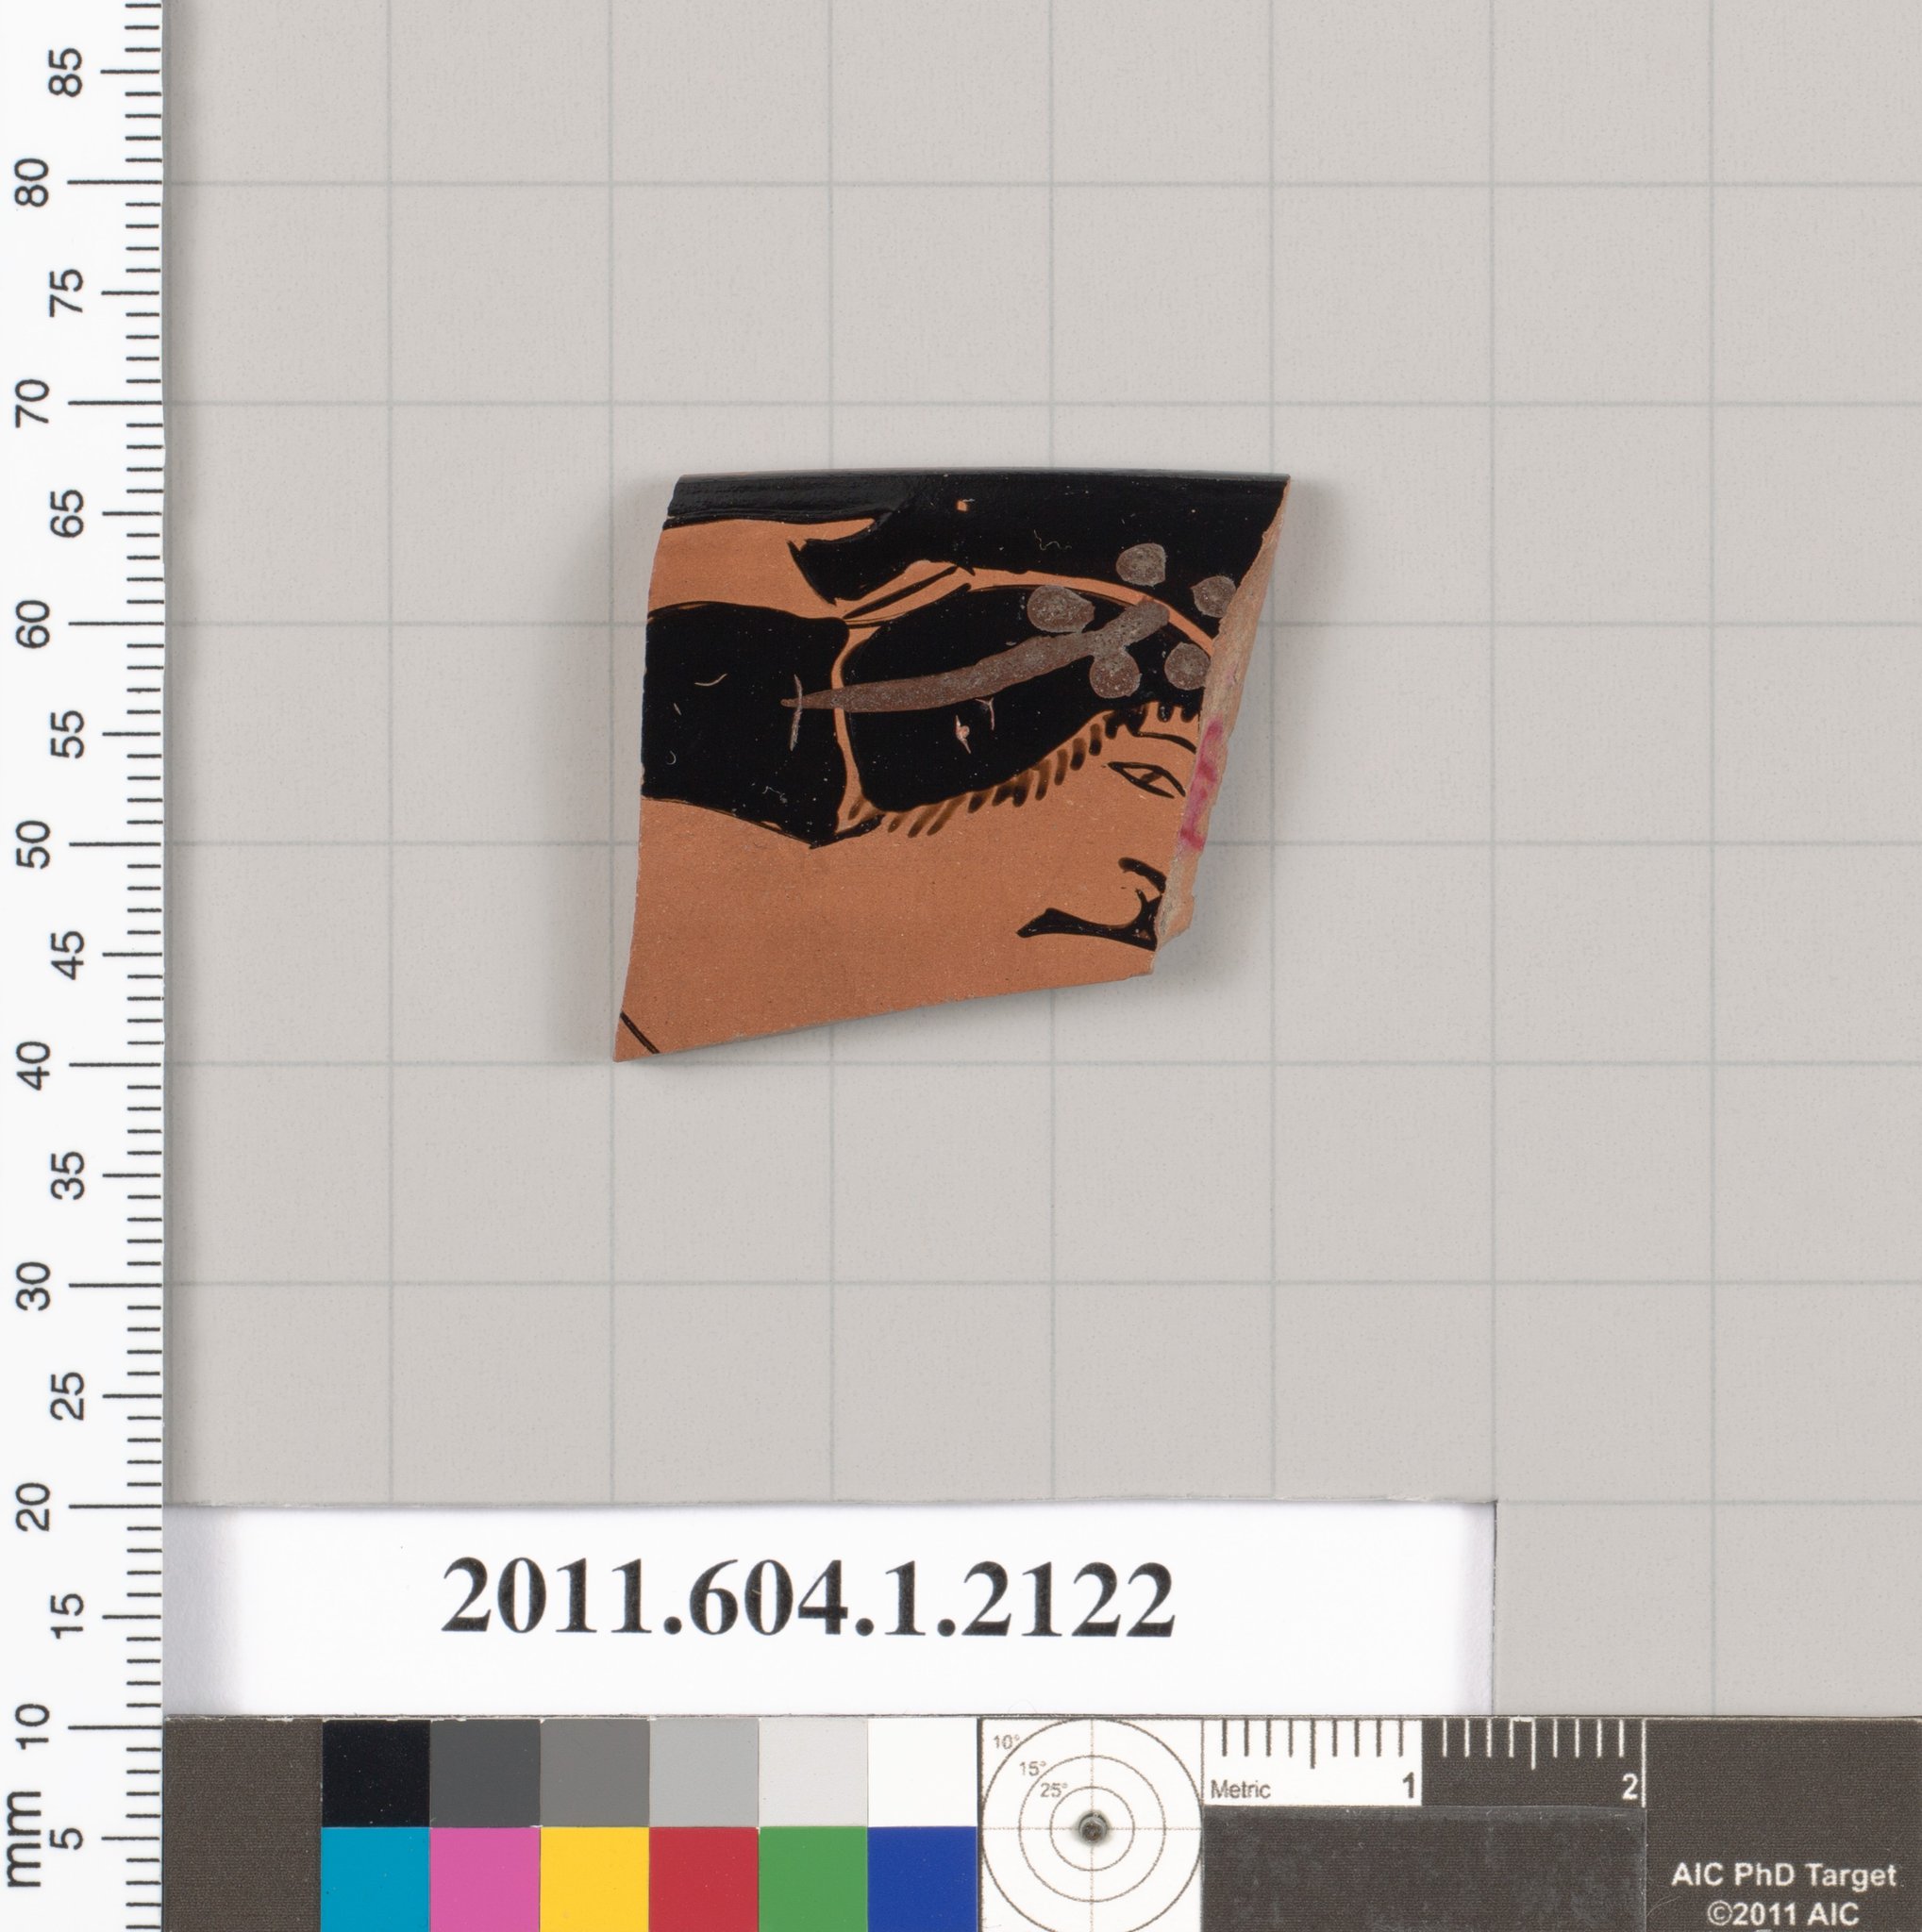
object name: kylix fragment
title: Terracotta rim fragment of a kylix (drinking cup)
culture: greek, attic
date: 534-468 BCE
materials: terracotta